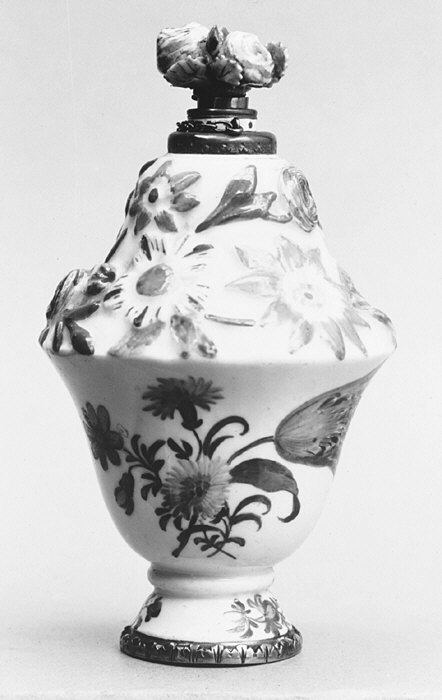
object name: scent bottle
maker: meissen manufactory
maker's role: manufactory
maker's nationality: german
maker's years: 1710-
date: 1770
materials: metal, porcelain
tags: flowers